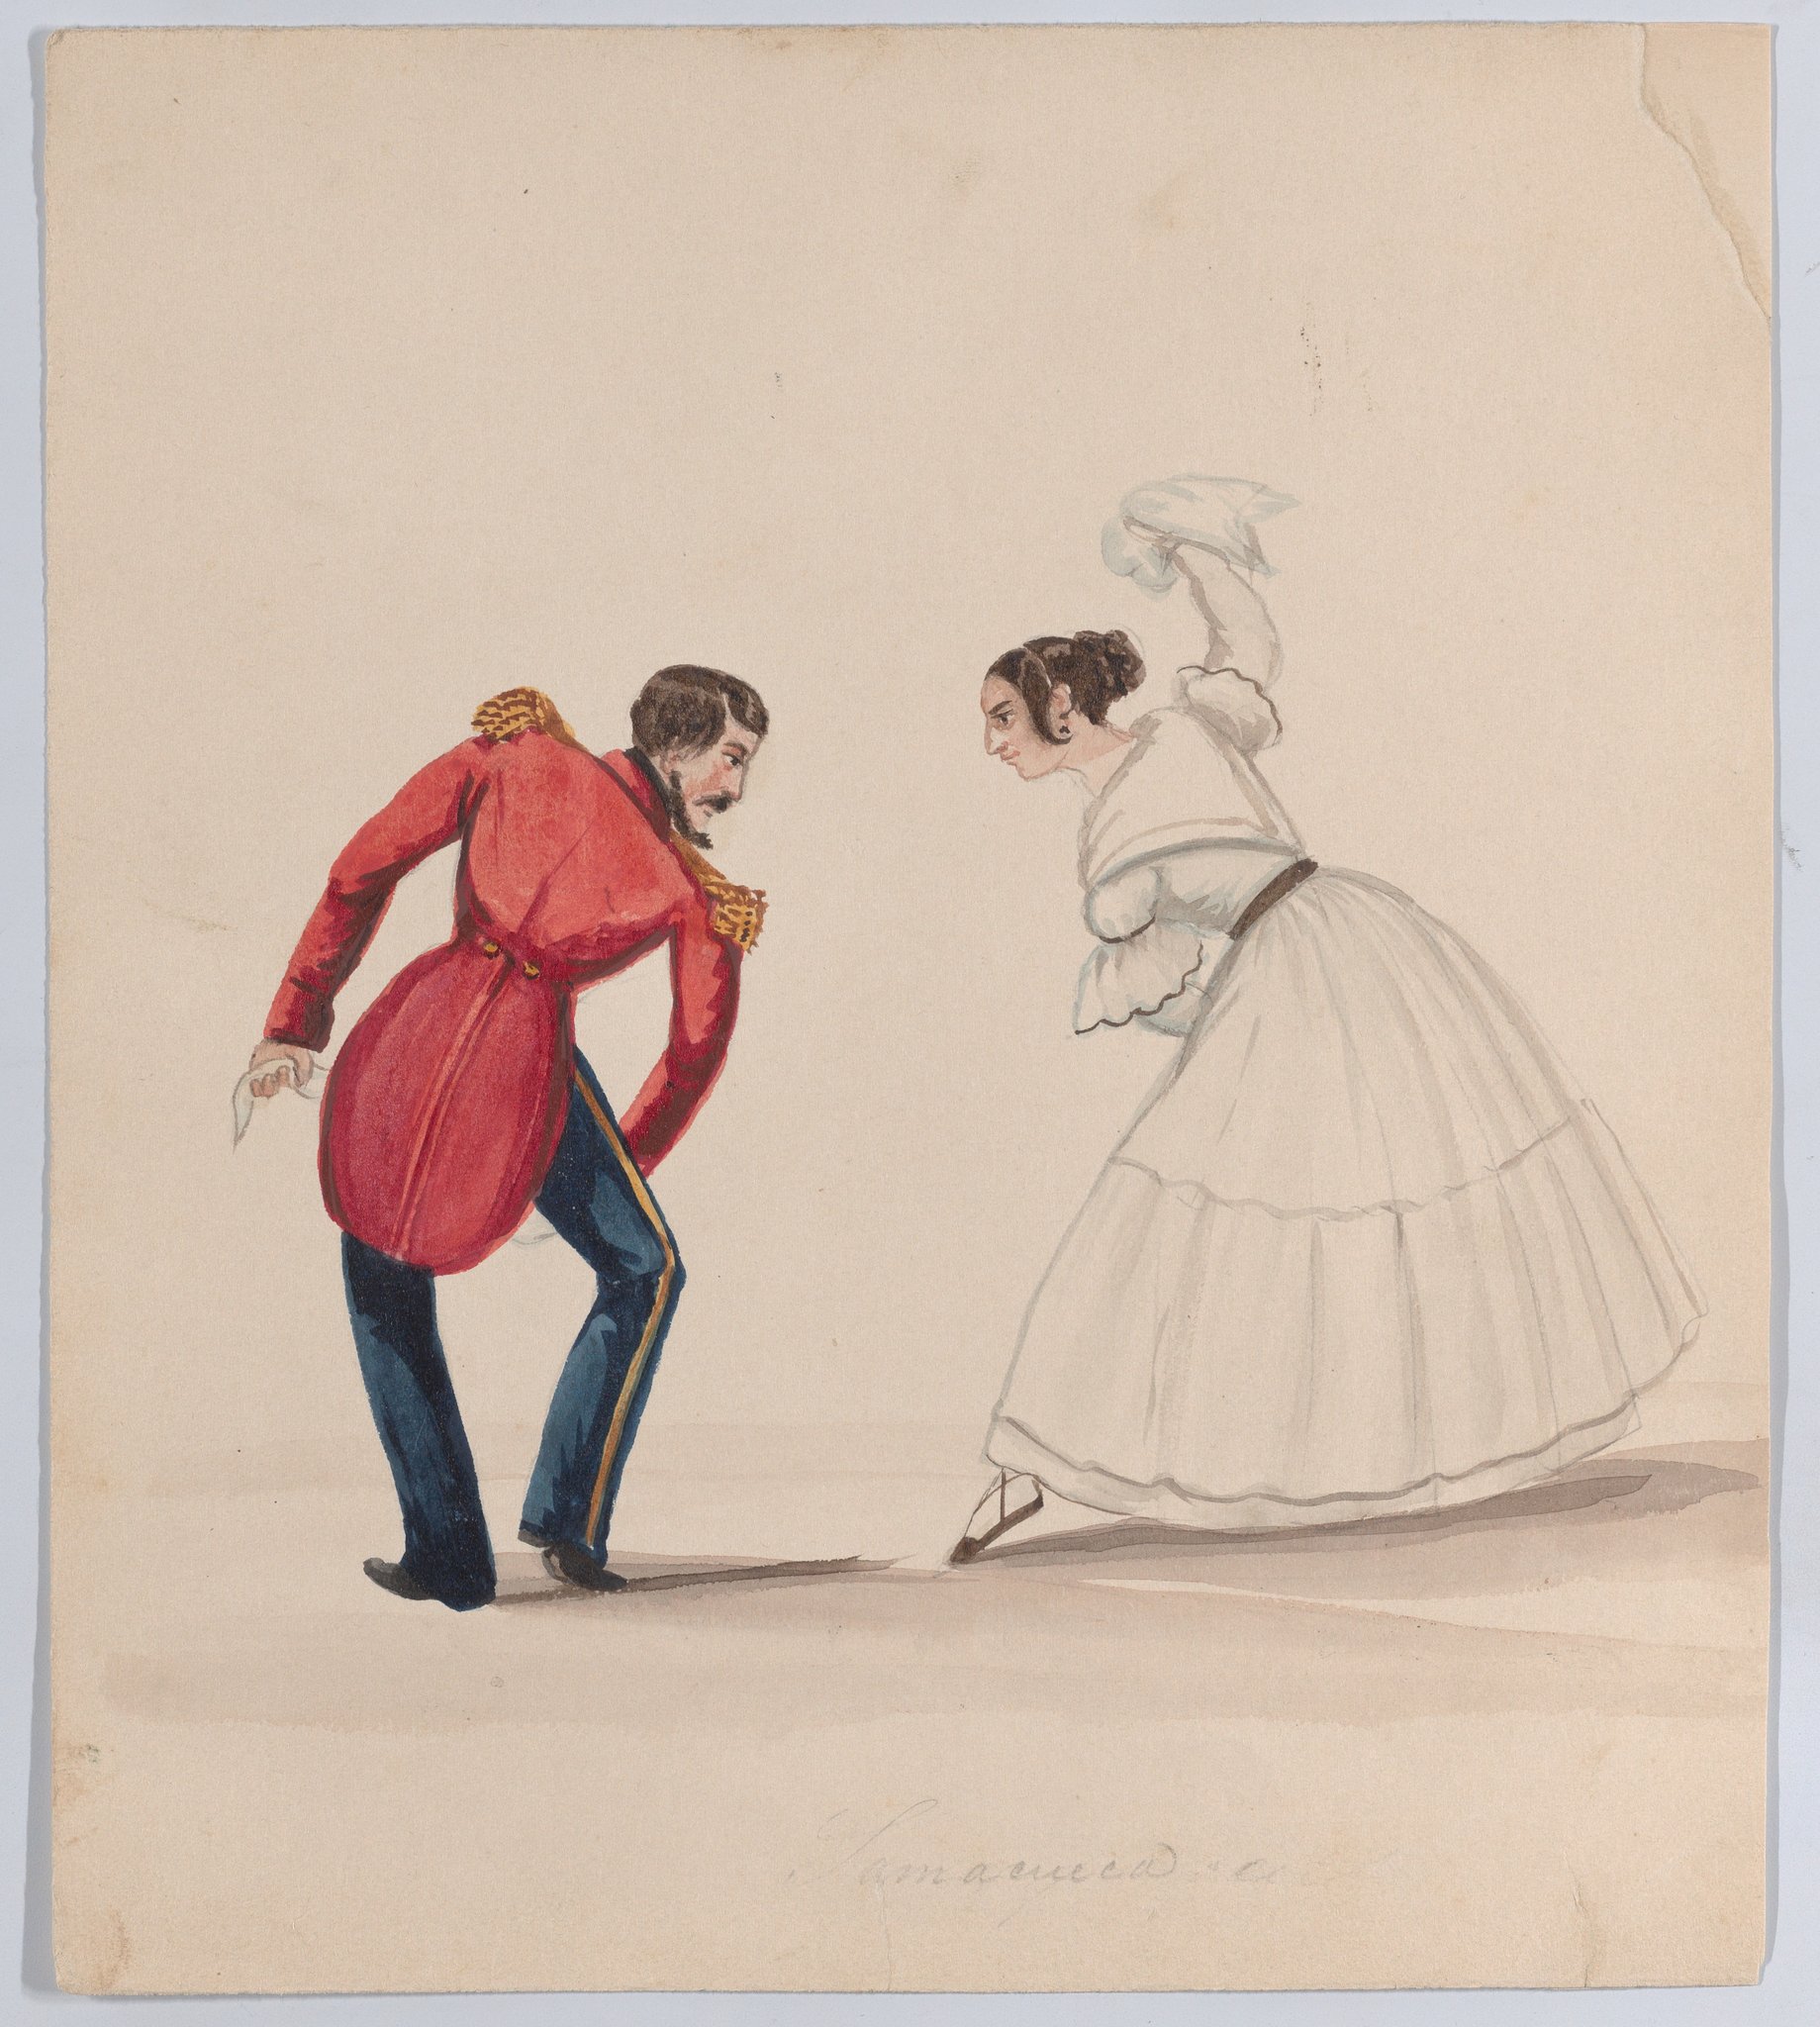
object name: drawing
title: A man and woman dancing the Zamacueca, from a group of drawings depicting Peruvian dress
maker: francisco (pancho) fierro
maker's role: artist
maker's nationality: african peruvian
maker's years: 1807-1879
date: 1848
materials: watercolor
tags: men,women